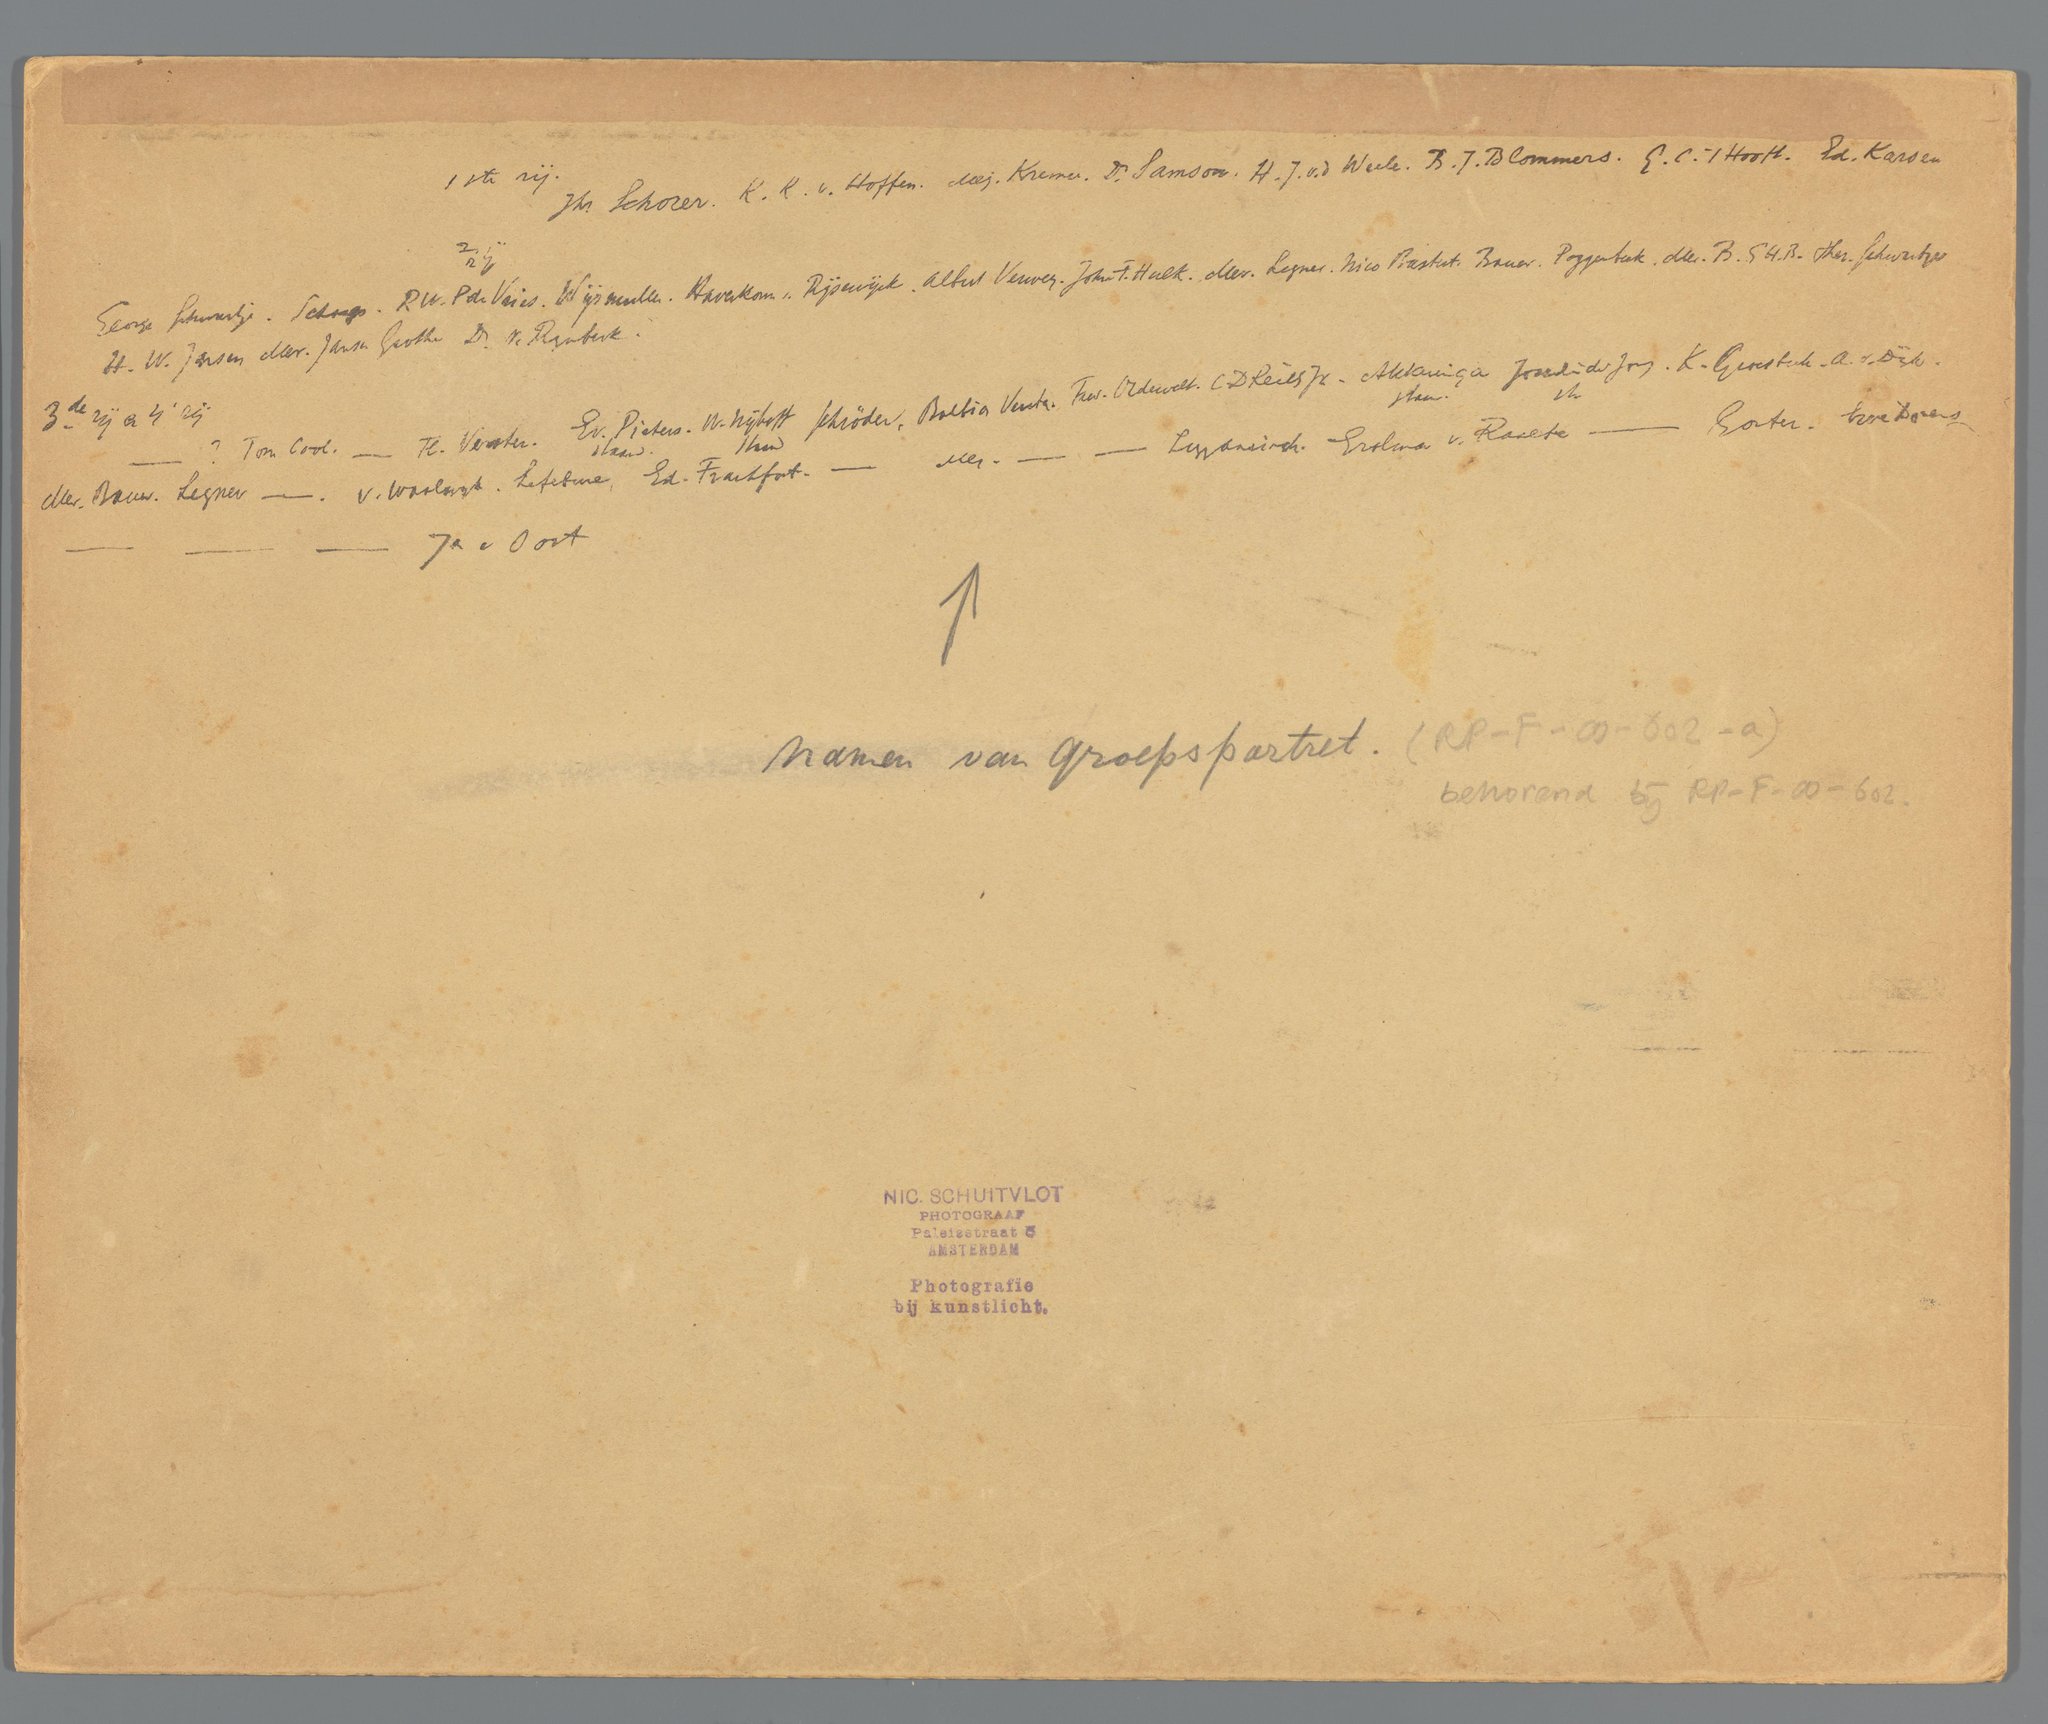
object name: passe partout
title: Passe-partout, oorspronkelijk toebehorend aan foto RP-F-00-602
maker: nicolaas schuitvlot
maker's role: fotograaf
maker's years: 1859-1947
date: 1883-1908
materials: cardboard, ink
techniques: pen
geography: amsterdam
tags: 'passe-partout'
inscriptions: inscription: ‘namen van groepsportret (RP-F-00-602-a)/ behorend bij RP-F-00-602.’, stamp: ‘Nic. Schuitvlot/ Photograaf/ Paleisstraat 5/ Amsterdam/ Photografie/ bij kunstlicht.’, inscription: ‘1ste rij: Jhr. Schorer (...) Ja. v. Oost’, inscription: ‘Photo diner’